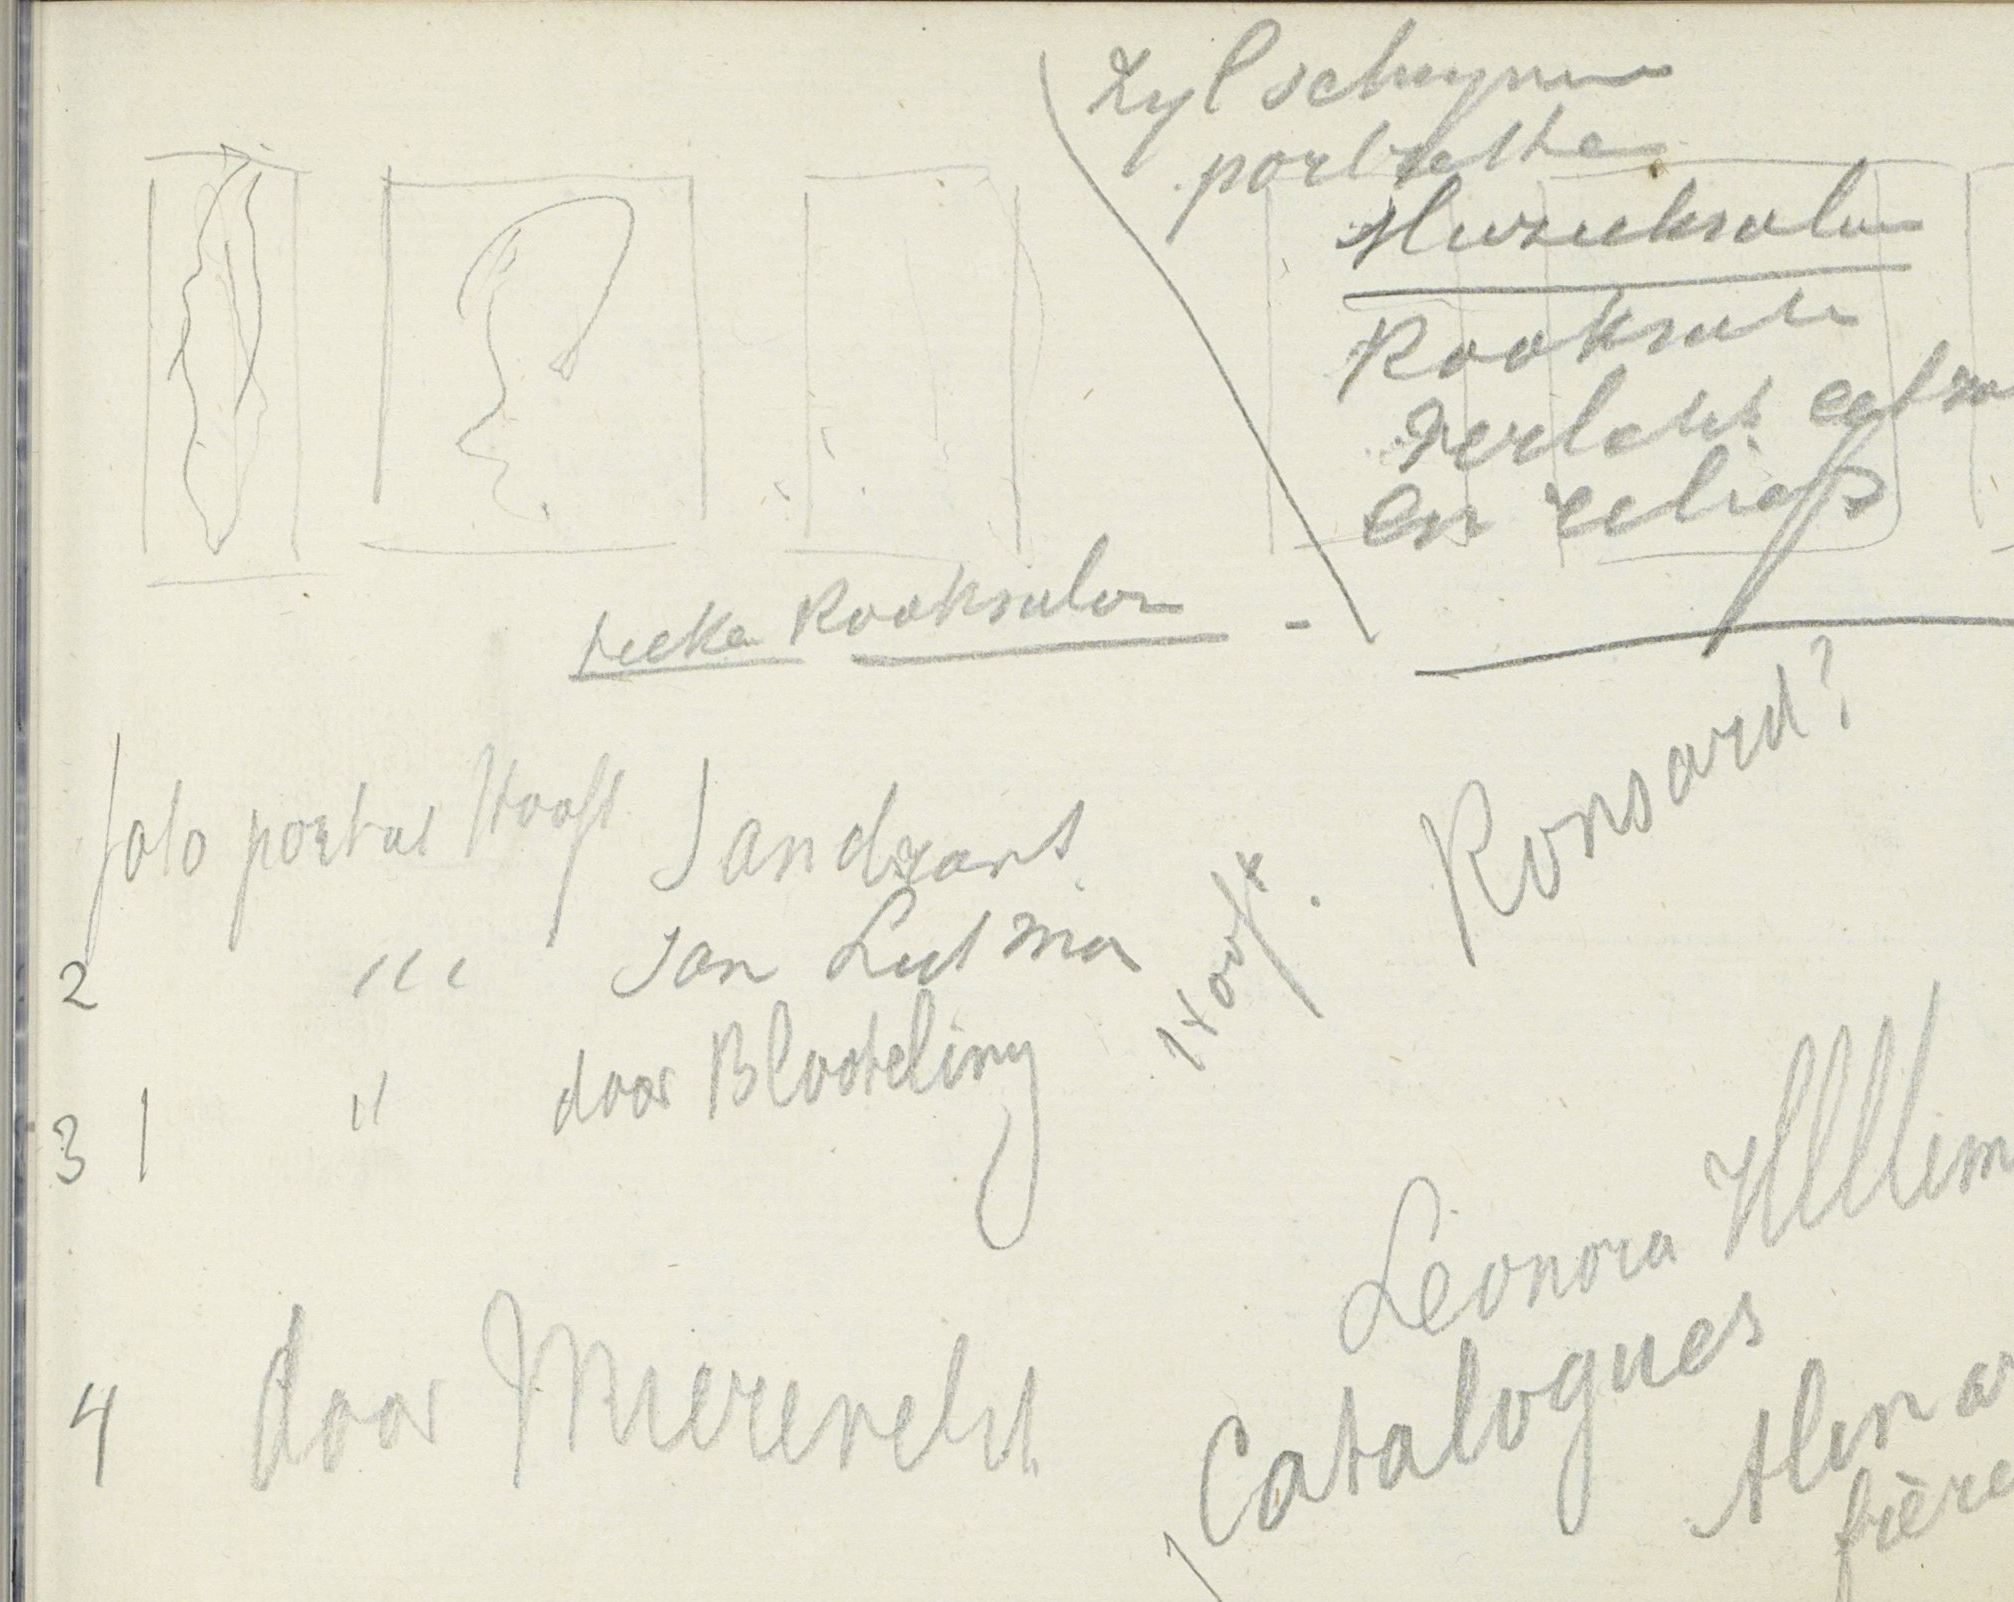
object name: sketchbook leaf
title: Ontwerpen voor reliëfs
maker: carel adolph lion cachet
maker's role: draughtsman, print maker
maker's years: 1864-1945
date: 1928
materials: paper, pencil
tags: art (+ relief ~ sculpture)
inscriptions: annotation: ‘zyl schr[...]/ por[...]/ Muzieksalon/ Rooksalon/ verlicht eetza[...]/ en reliefs/ teeken Rooksalon/ [...] Ronsard?/ Leonora H[...]mars/ catalogues/ A[...]/ frères’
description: Blad 16 recto uit een schetsboek met 24 bladen.